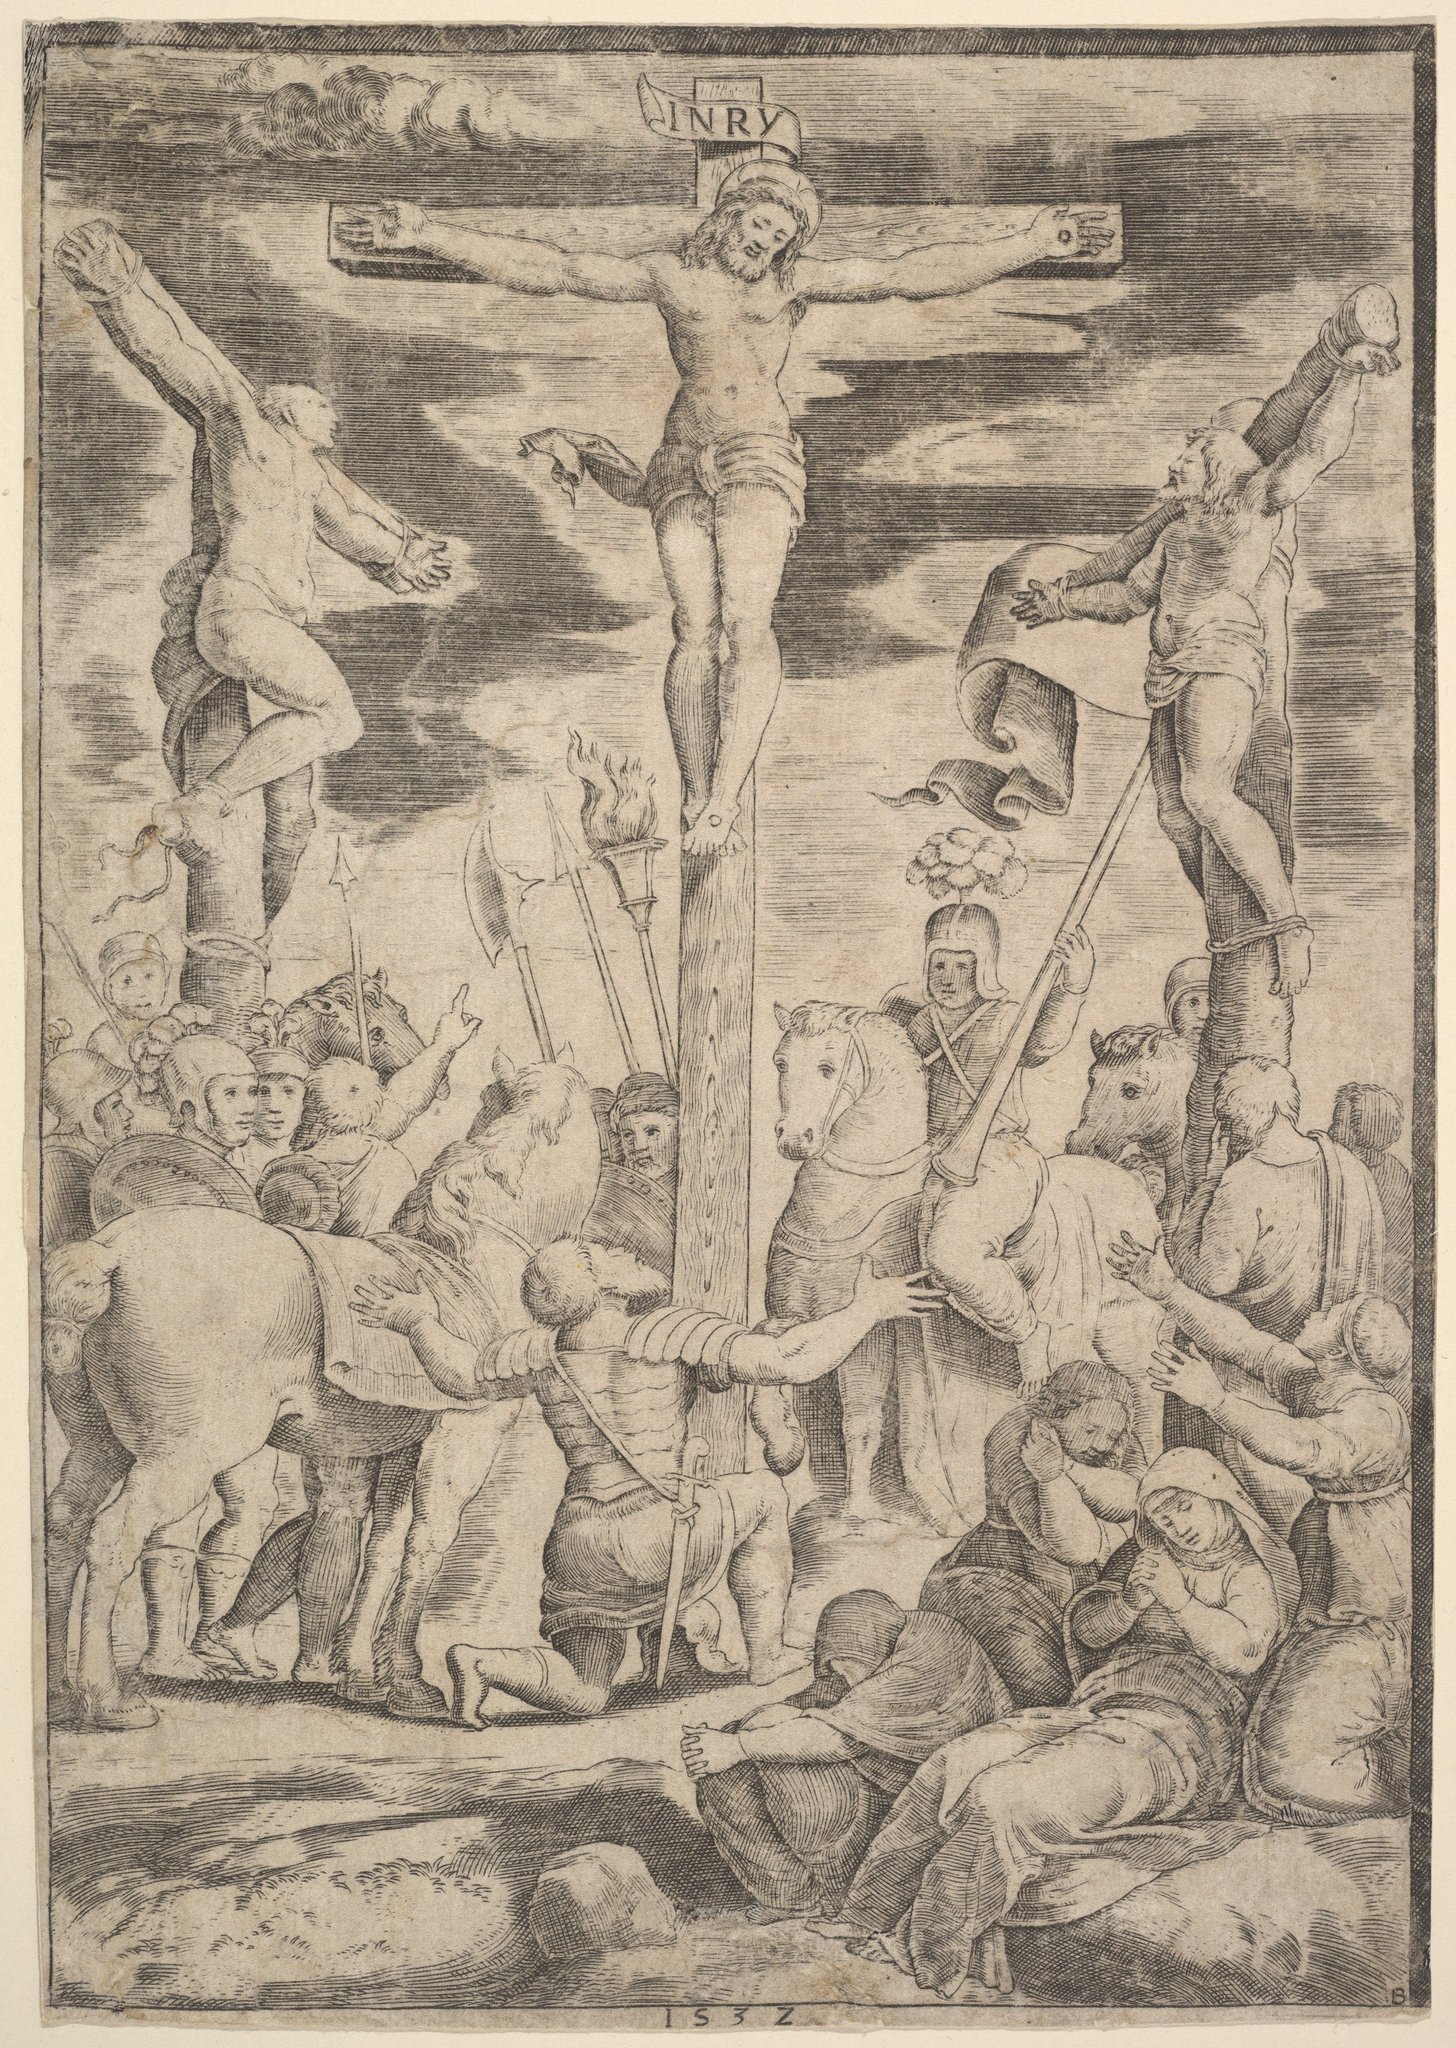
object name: print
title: The conversion of the Centurion who flings his arms open before Christ on the cross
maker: master of the die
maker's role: artist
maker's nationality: italian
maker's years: 1525-1560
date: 1532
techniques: engraving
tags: christ,crucifixion